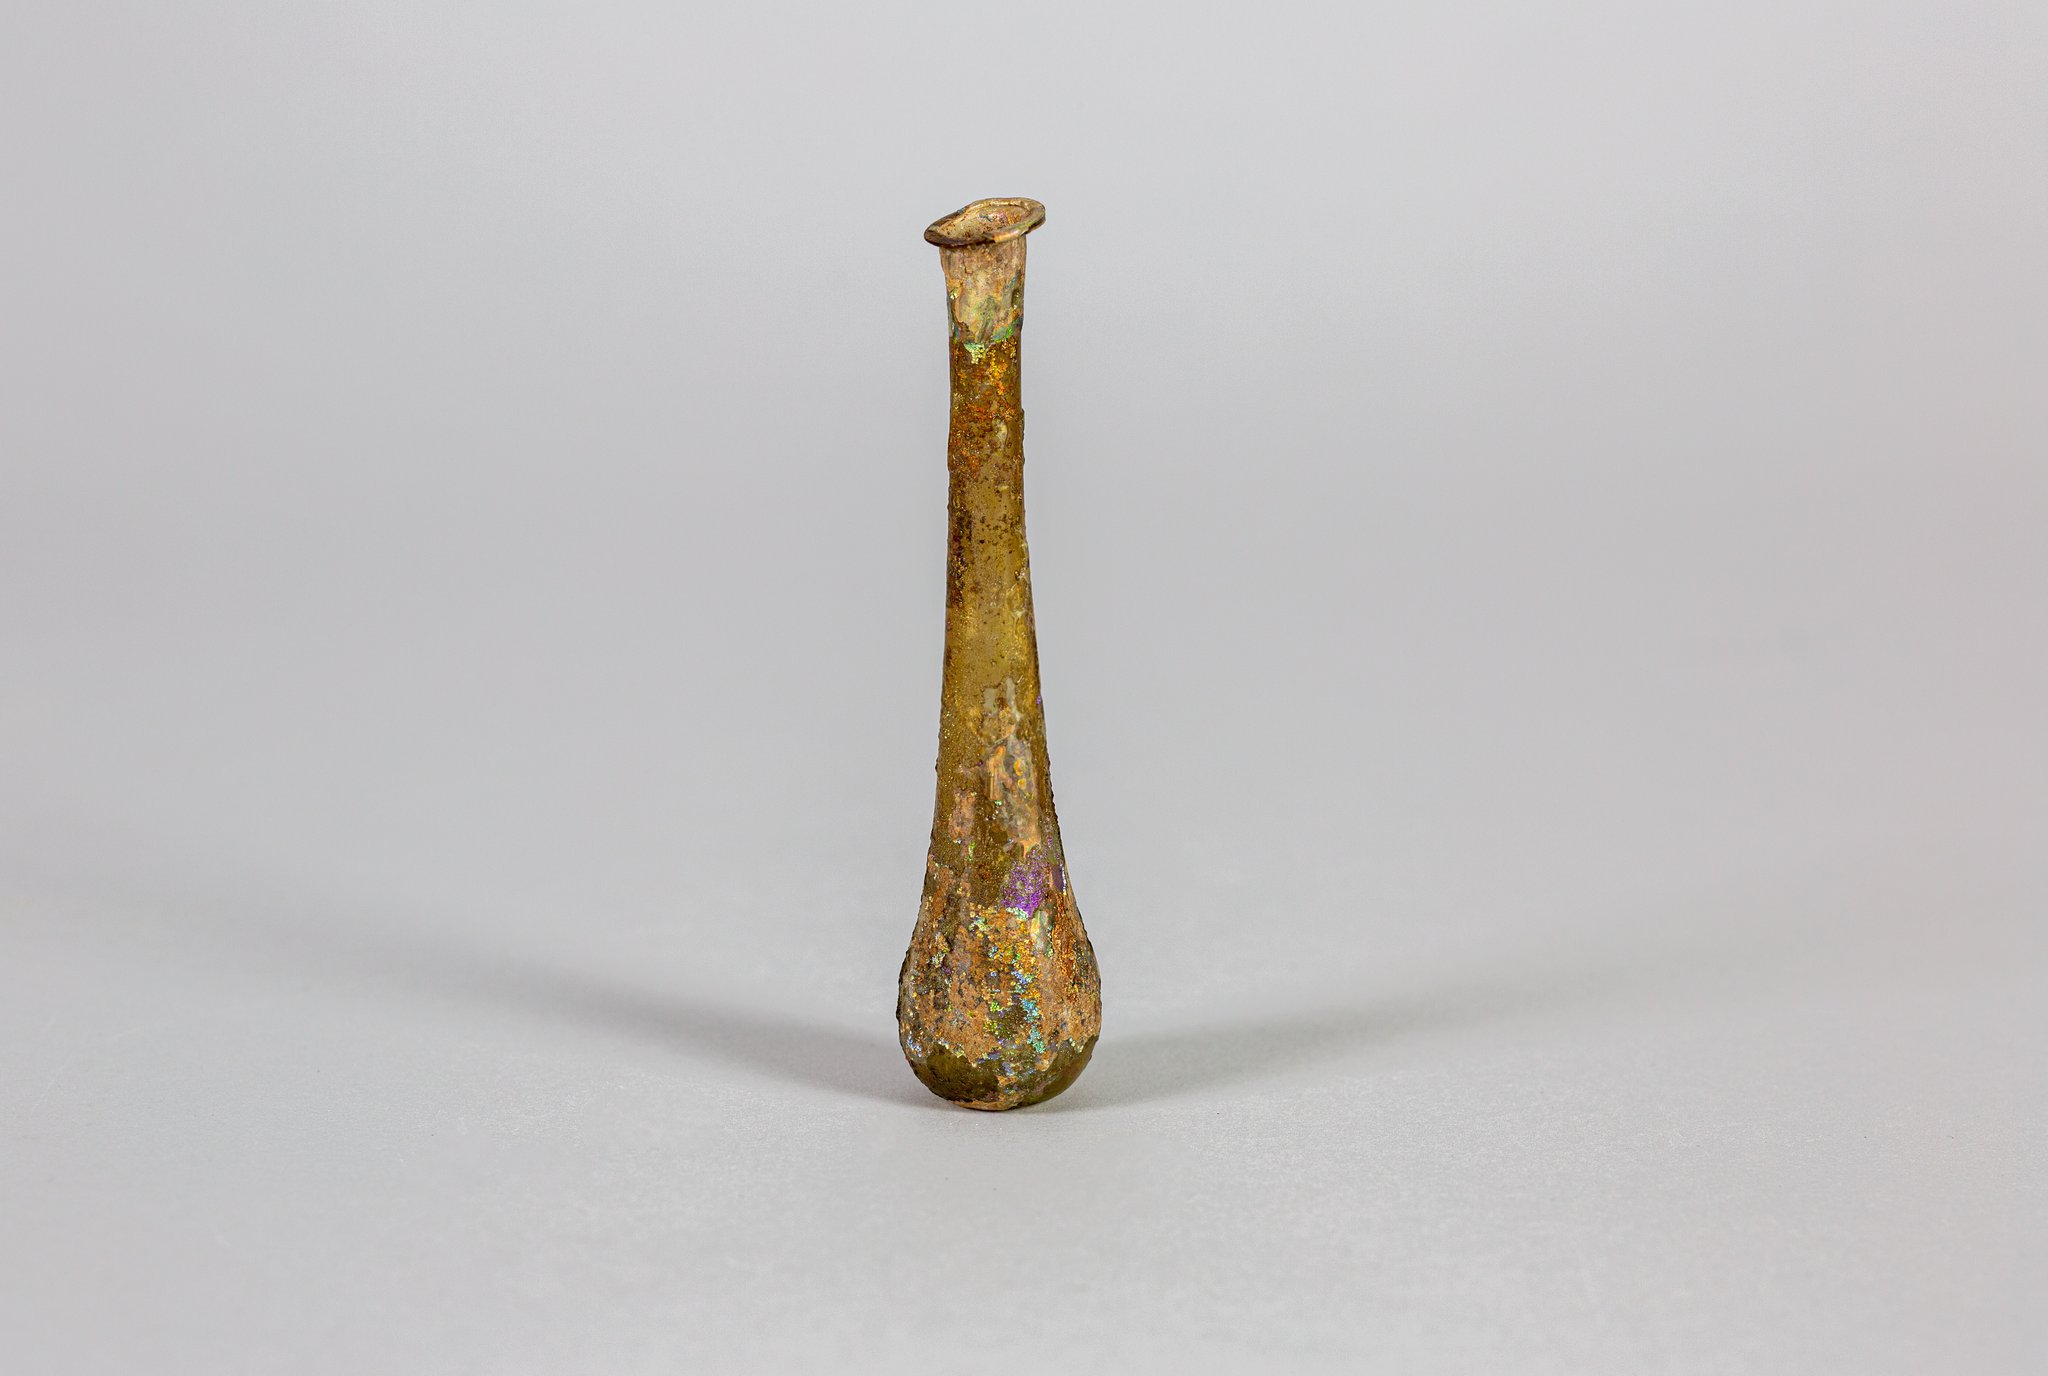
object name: perfume bottle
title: Glass perfume bottle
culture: roman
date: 67-300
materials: glass